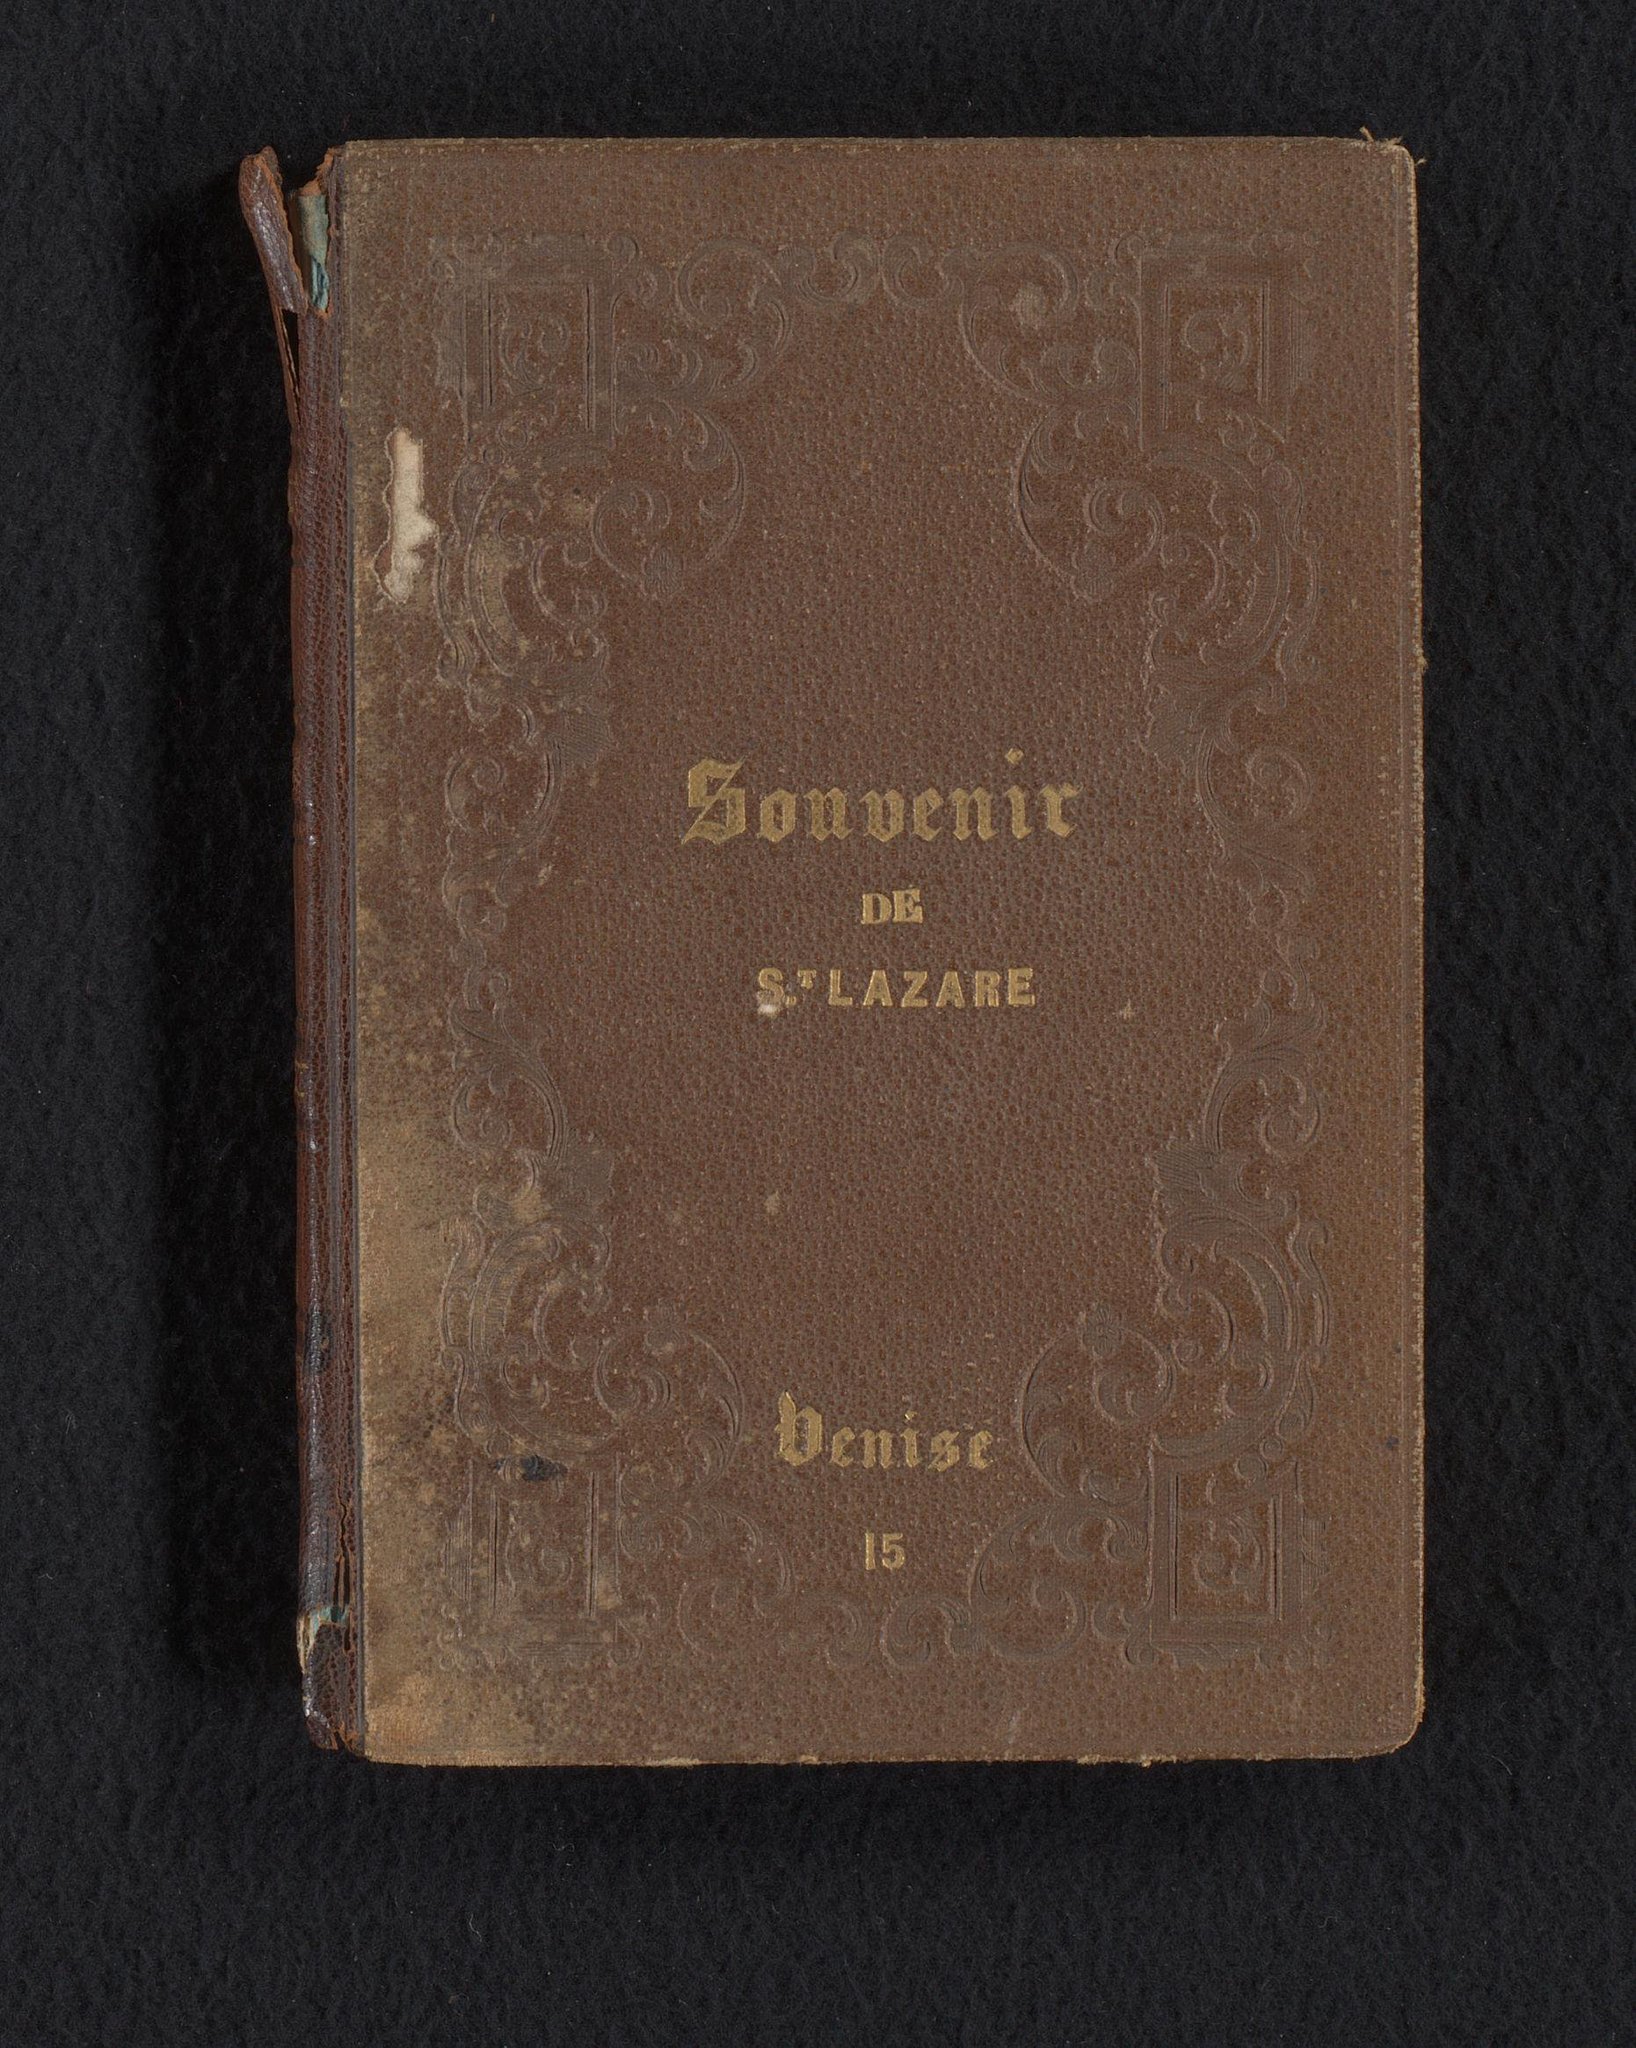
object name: book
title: Souvenir de St. Lazare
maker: Anonymous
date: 1870-1890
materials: cardboard, leather, paper, textile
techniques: albumen print, hand coloring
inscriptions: inscription: ‘S9/ 8.’, inscription: ‘VENISE/ 15’